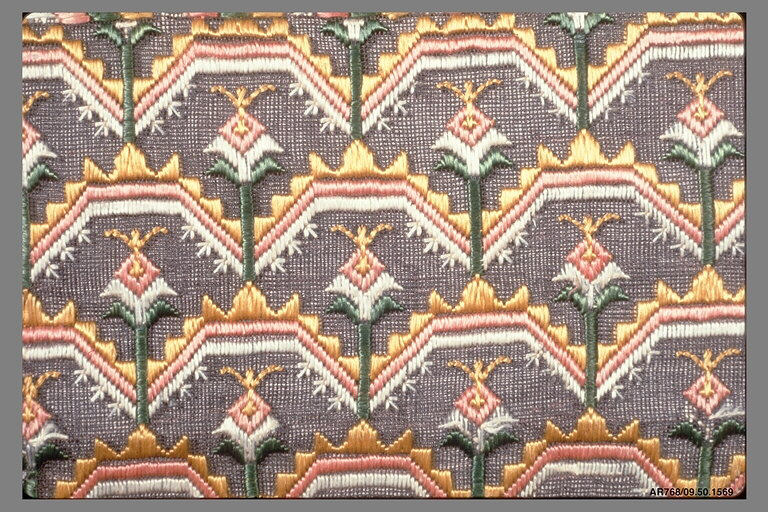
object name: fragment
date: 1801-1900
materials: silk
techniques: embroidery